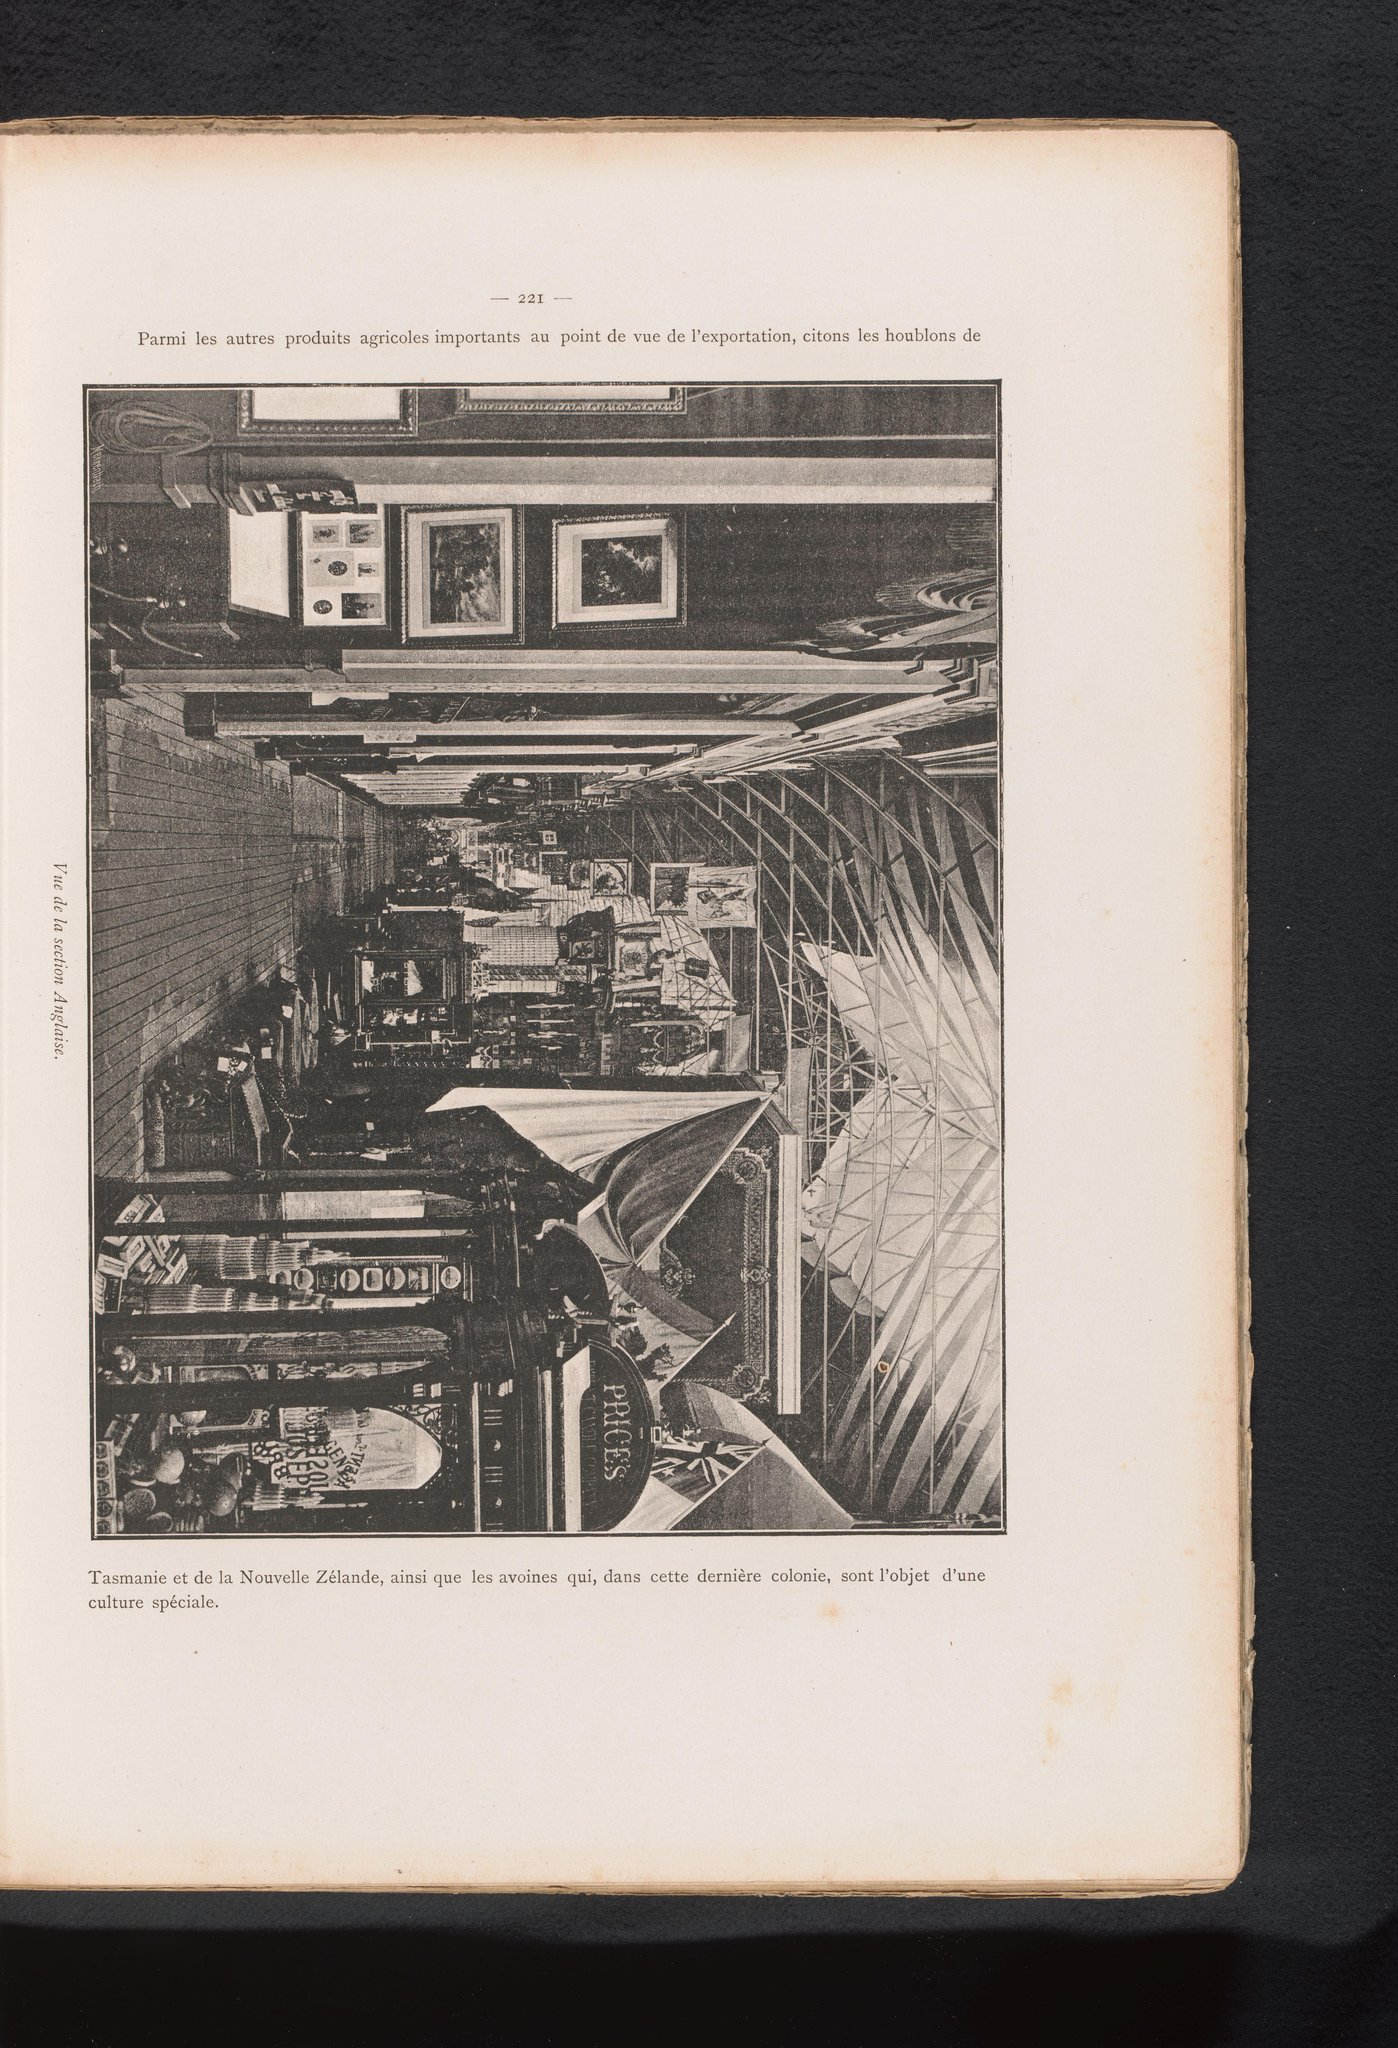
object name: photomechanical print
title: Gezicht op het Engelse deel van de Wereldtentoonstelling van 1885 in Antwerpen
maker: Anonymous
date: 1880-1885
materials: paper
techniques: autotype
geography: antwerp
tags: world fair, world exhibition, antwerp